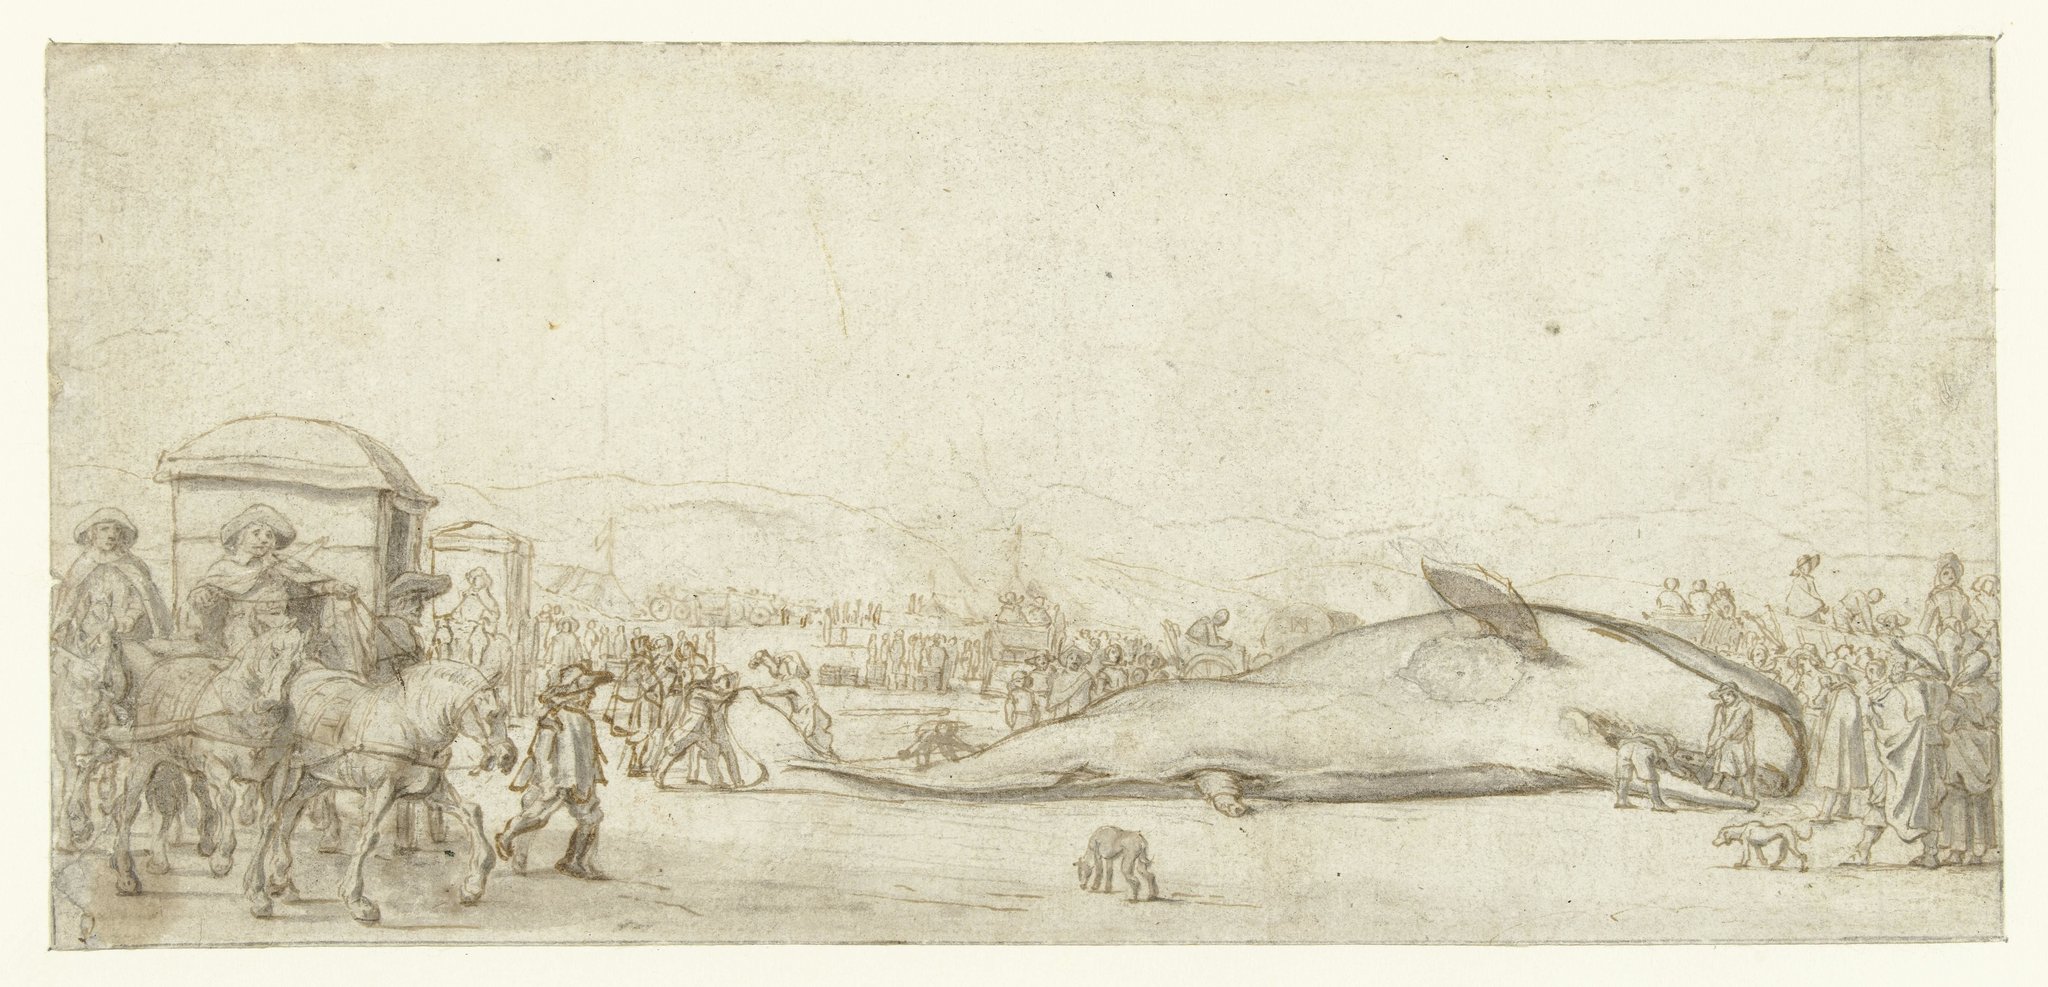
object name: drawing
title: De gestrande potvis te Noordwijk in 1629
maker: esaias van de velde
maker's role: draughtsman, painter, print maker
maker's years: 1587-1630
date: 1601-1629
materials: chalk, ink, paper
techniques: brush, pen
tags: swimming mammals: whale (+ dying animal; death of animal; dead animal), beach, historical events and situations